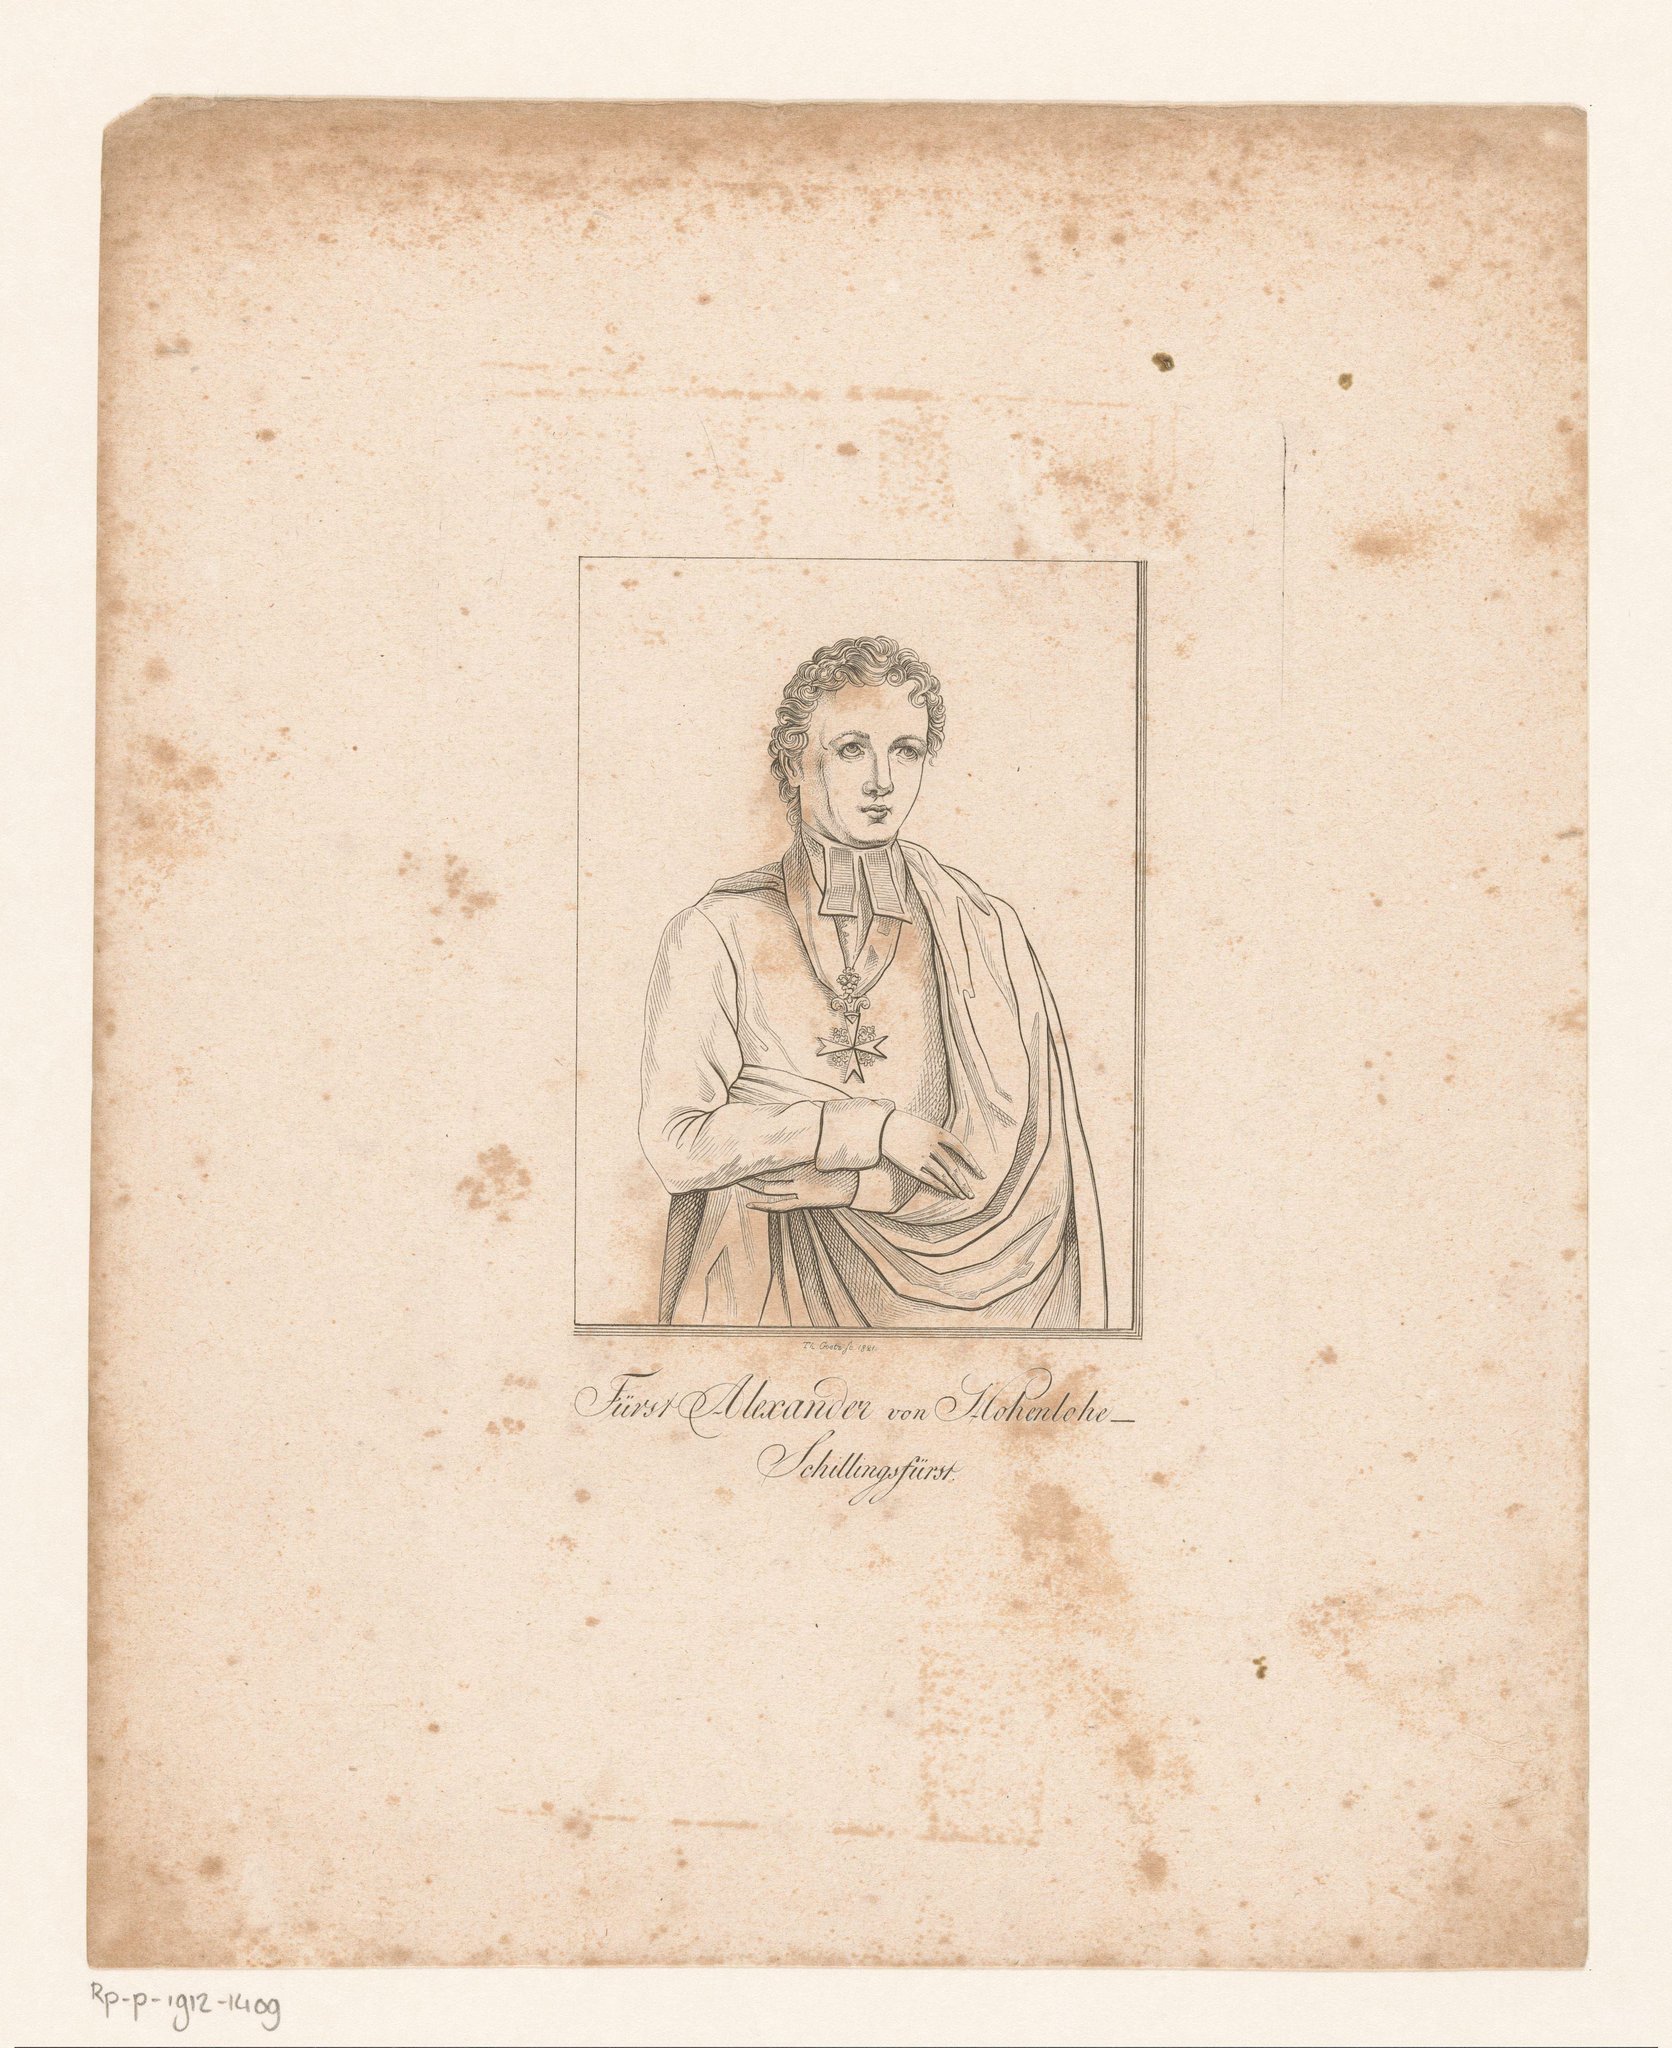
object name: print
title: Portret van Alexander zu Hohenlohe-Waldenburg-Schillingsfürst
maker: theodor götz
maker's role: painter, print maker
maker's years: 1779-1853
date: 1821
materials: paper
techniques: engraving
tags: historical persons, pendant, trinket, 'breloque'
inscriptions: collector's mark: Lugt 2228